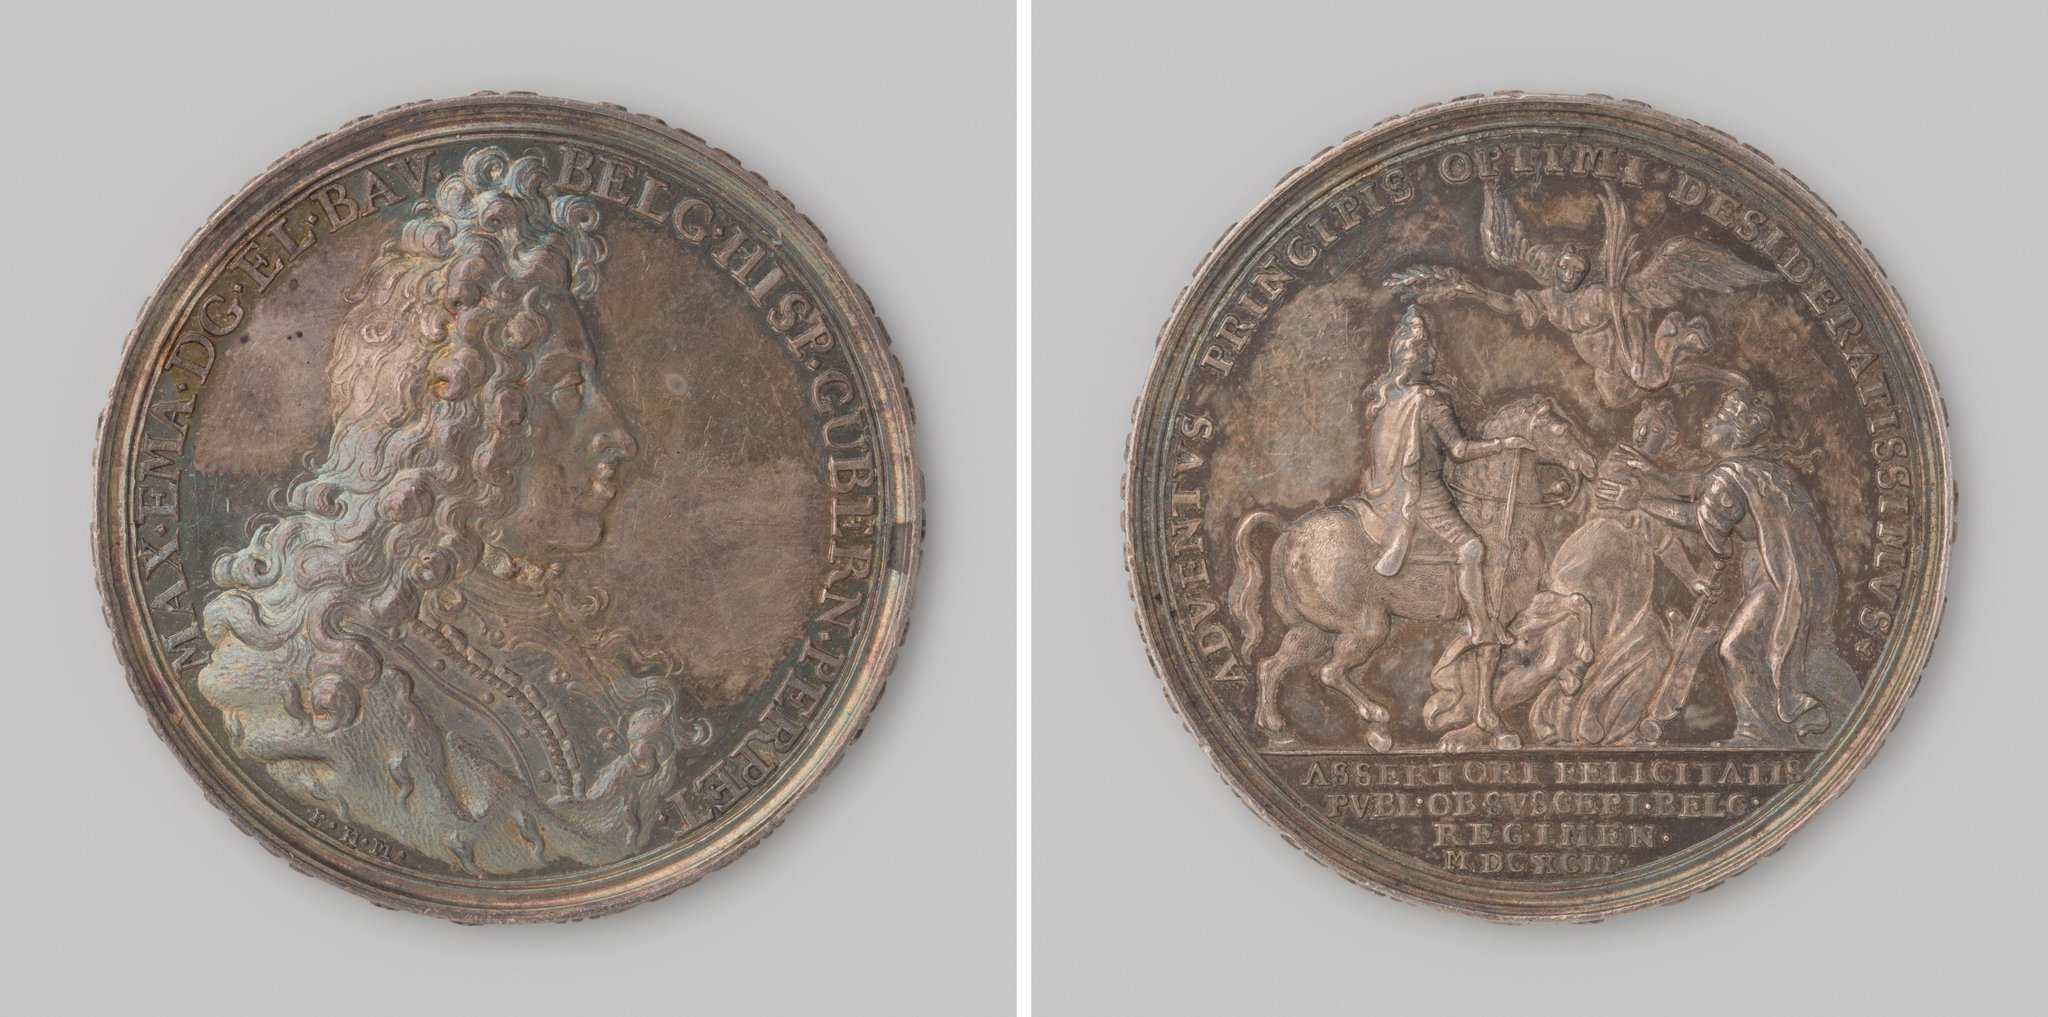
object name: history medal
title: Aankomst van Maximiliaan Emanuel van Beieren als landvoogd over de Spaanse Nederlanden 1692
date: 1692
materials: silver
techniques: striking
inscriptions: edge inscription: ‘SPES ERECTÆ IN TE BATAVVM, TE PVBLICA VOTA EXCIPIVNT. ...(.FK.)...’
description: Zilveren penning, op de voorzijde het borstbeeld van Maximiliaan Emanuel met omschrift, op de keerzijde Maximiliaan te paard, gelauwerd door een vliegende Victoria en vergezeld door Fortuna, begroet door de inwoners van de Spaanse Nederlanden, met omschrift en afsnedetekst.